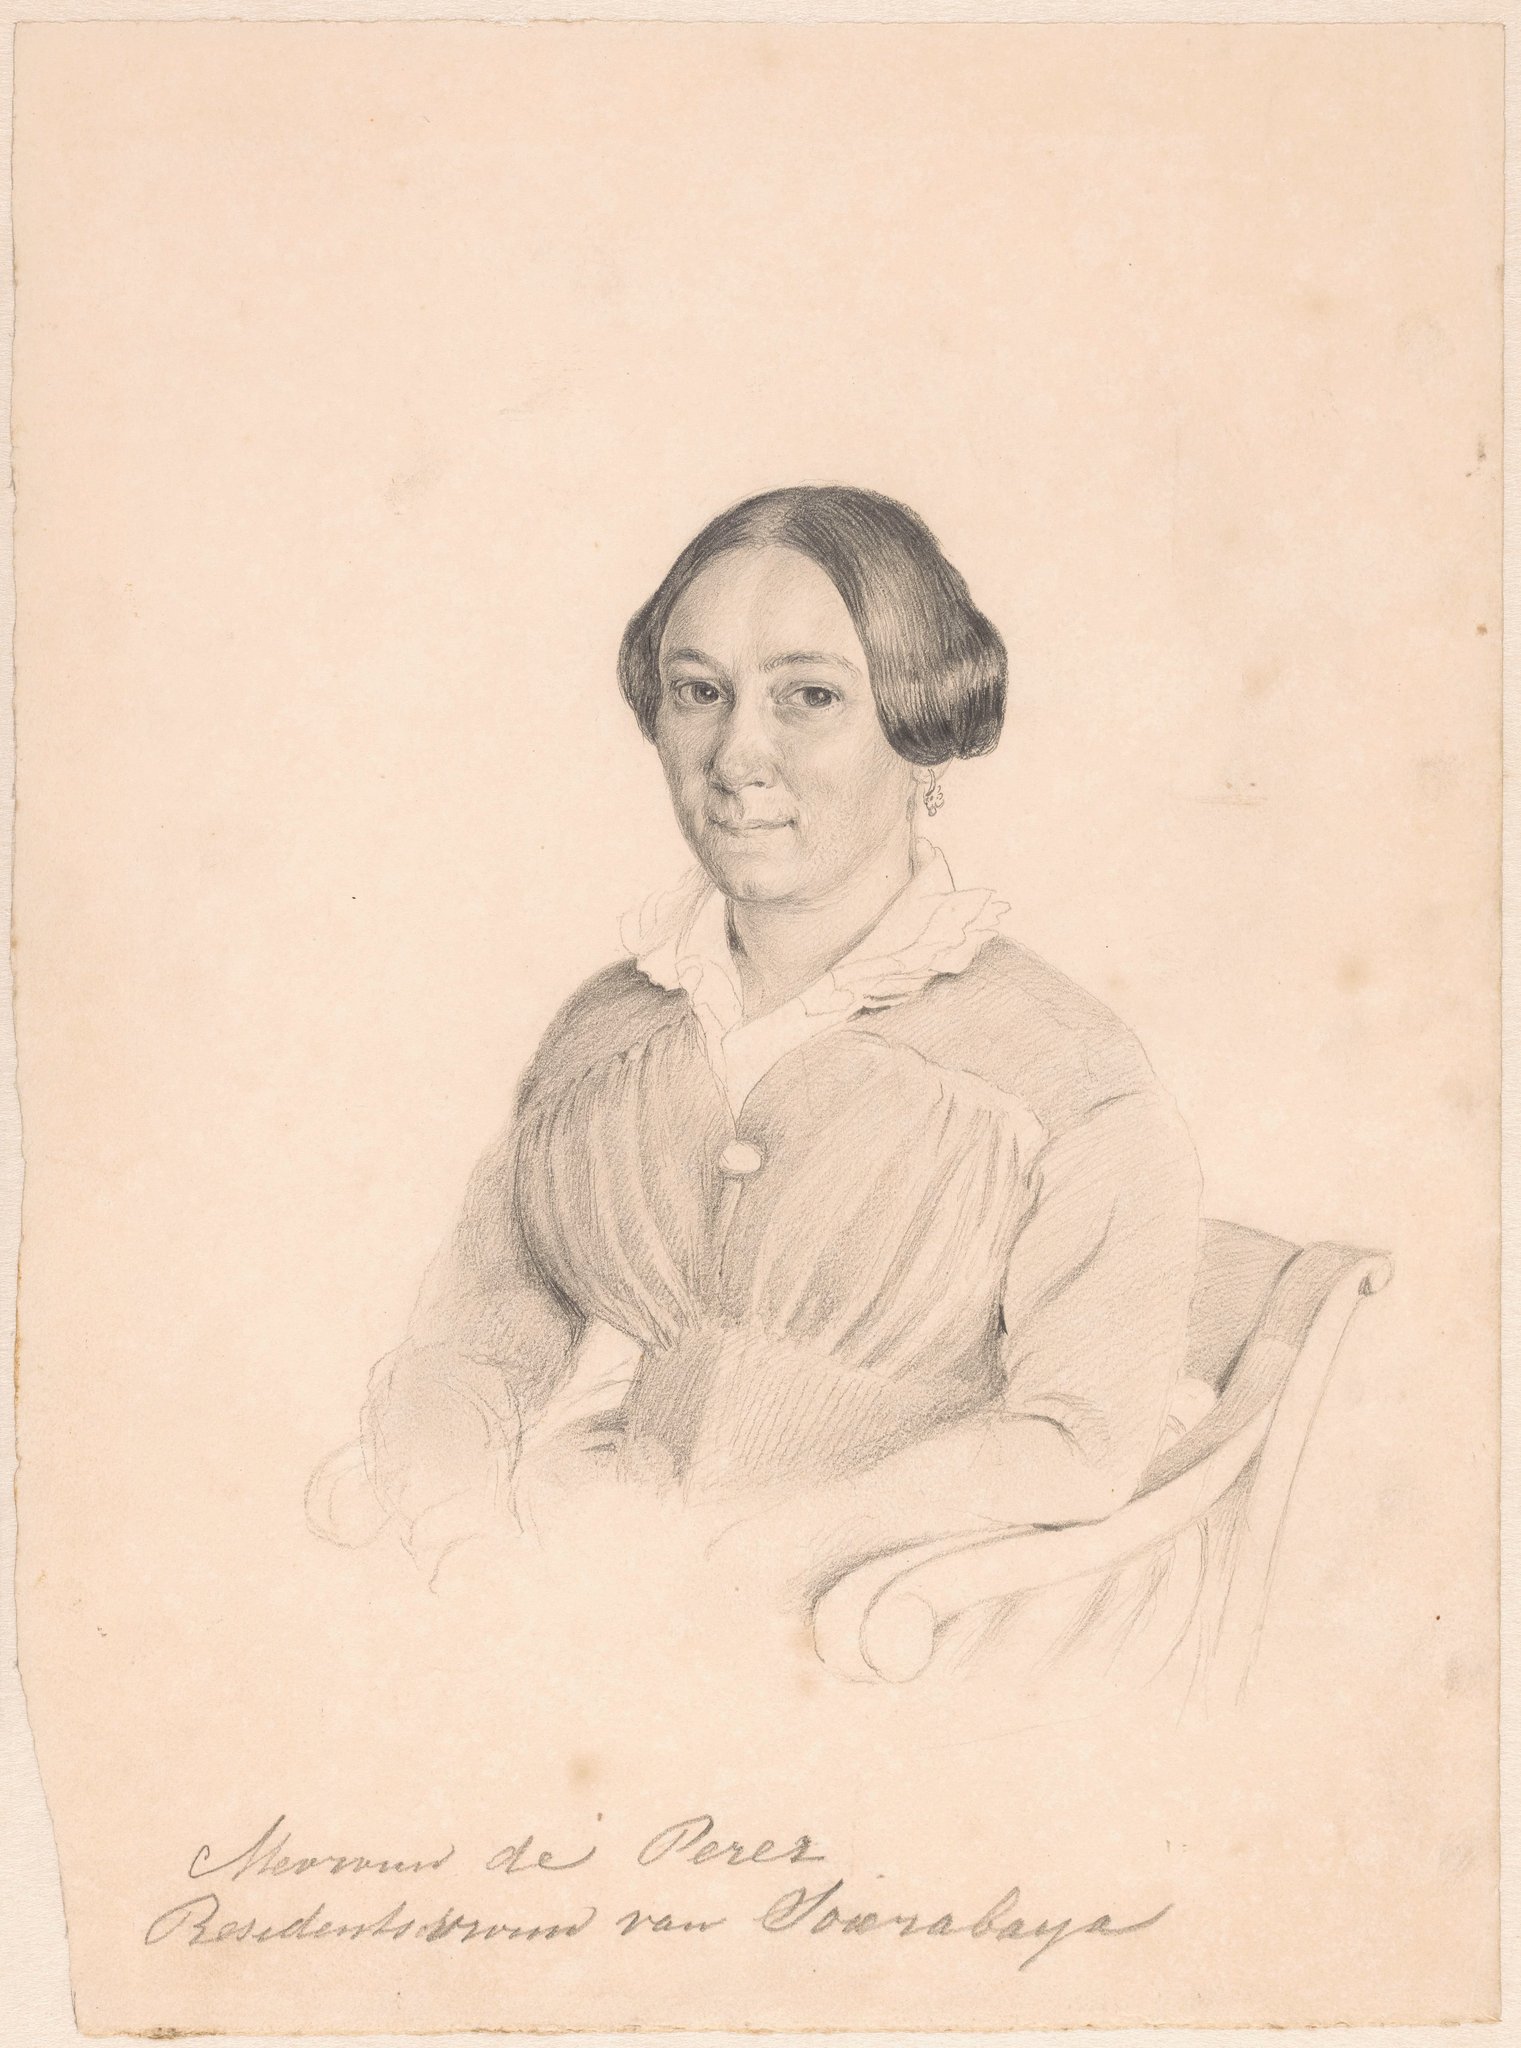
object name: drawing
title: Portret van mevrouw de Perez, residensvrouw van Sourabaya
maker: christian heinrich gottlieb steuerwald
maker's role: draughtsman, print maker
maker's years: 1802-1874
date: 1850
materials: paper, pencil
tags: sitting figure, historical persons, male sex; man